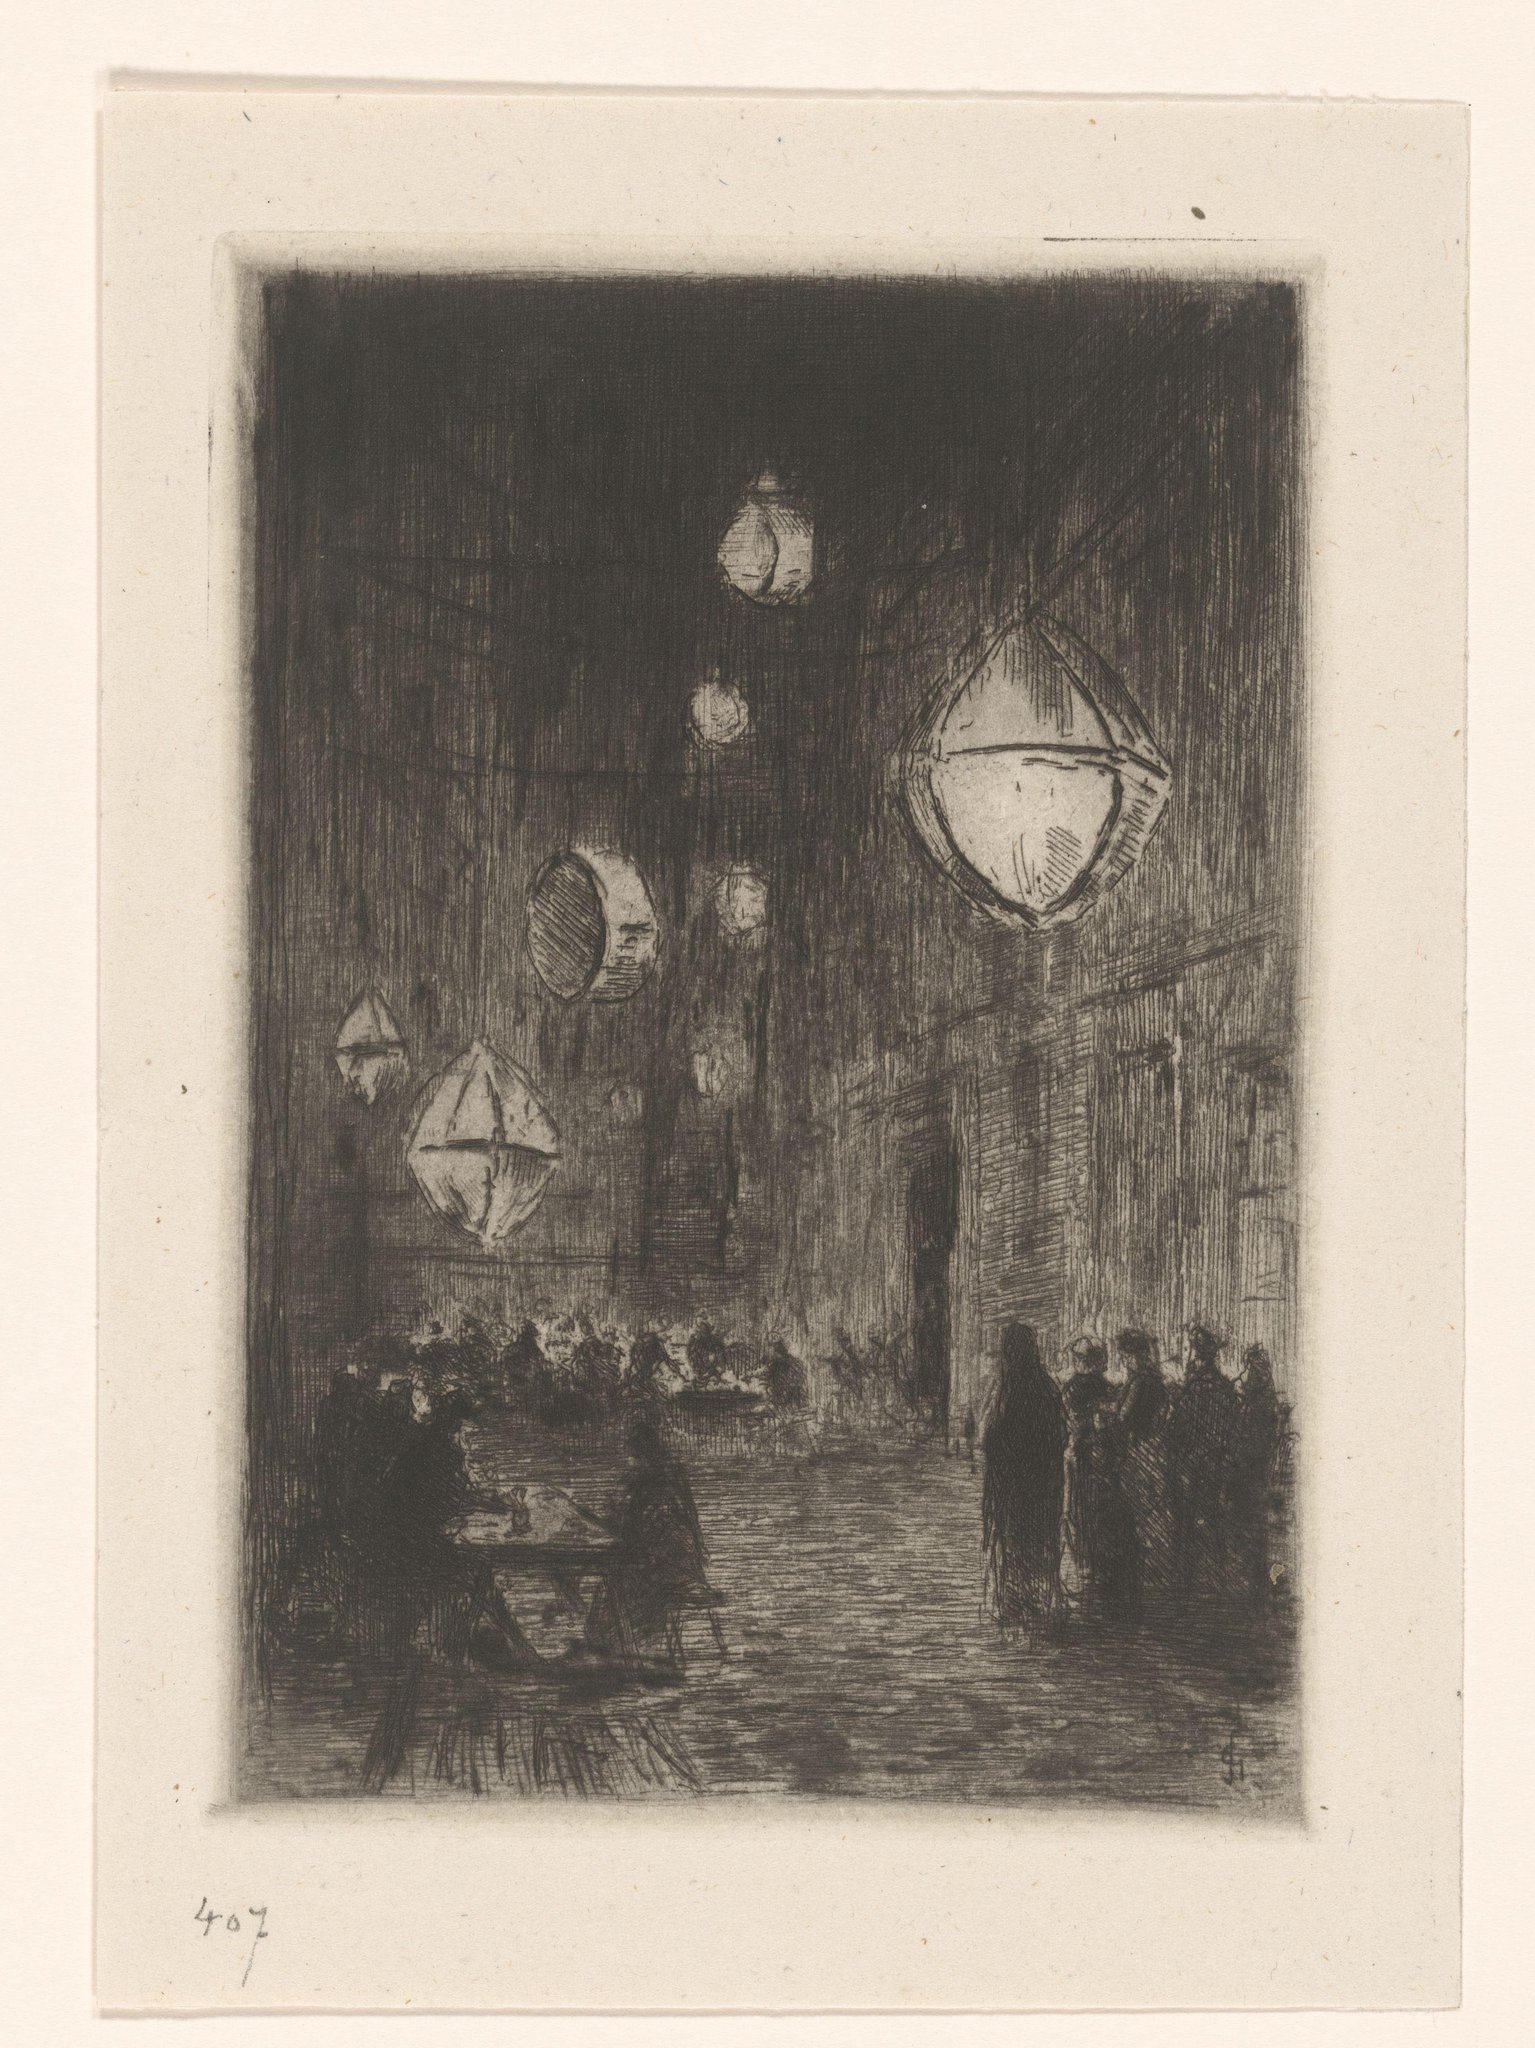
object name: print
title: Straatfeest met lampionnen in Venetië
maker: carel nicolaas storm van s-gravesande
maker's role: draughtsman, print maker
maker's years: 1841-1924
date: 1851-1902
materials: paper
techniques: drypoint, etching, intaglio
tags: lantern, street (+ city(-scape) with figures, staffage), venice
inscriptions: collector's mark: Lugt 2228, number: ‘407’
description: Mogelijk vermeld in: Storm van 's-Gravesande, Charles. Catalogue des eaux-fortes et lithographies. New York: s.n., 1903, of in een onbekende latere uitgave van het manuscript. Vermoedelijk vermeld als catalogusnummer 407.